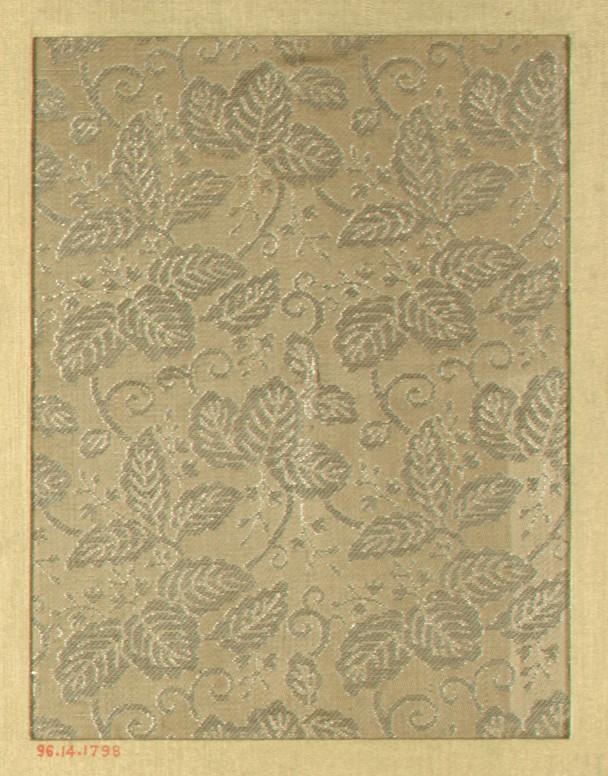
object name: piece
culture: japanese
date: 1701-1900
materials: silk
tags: leaves